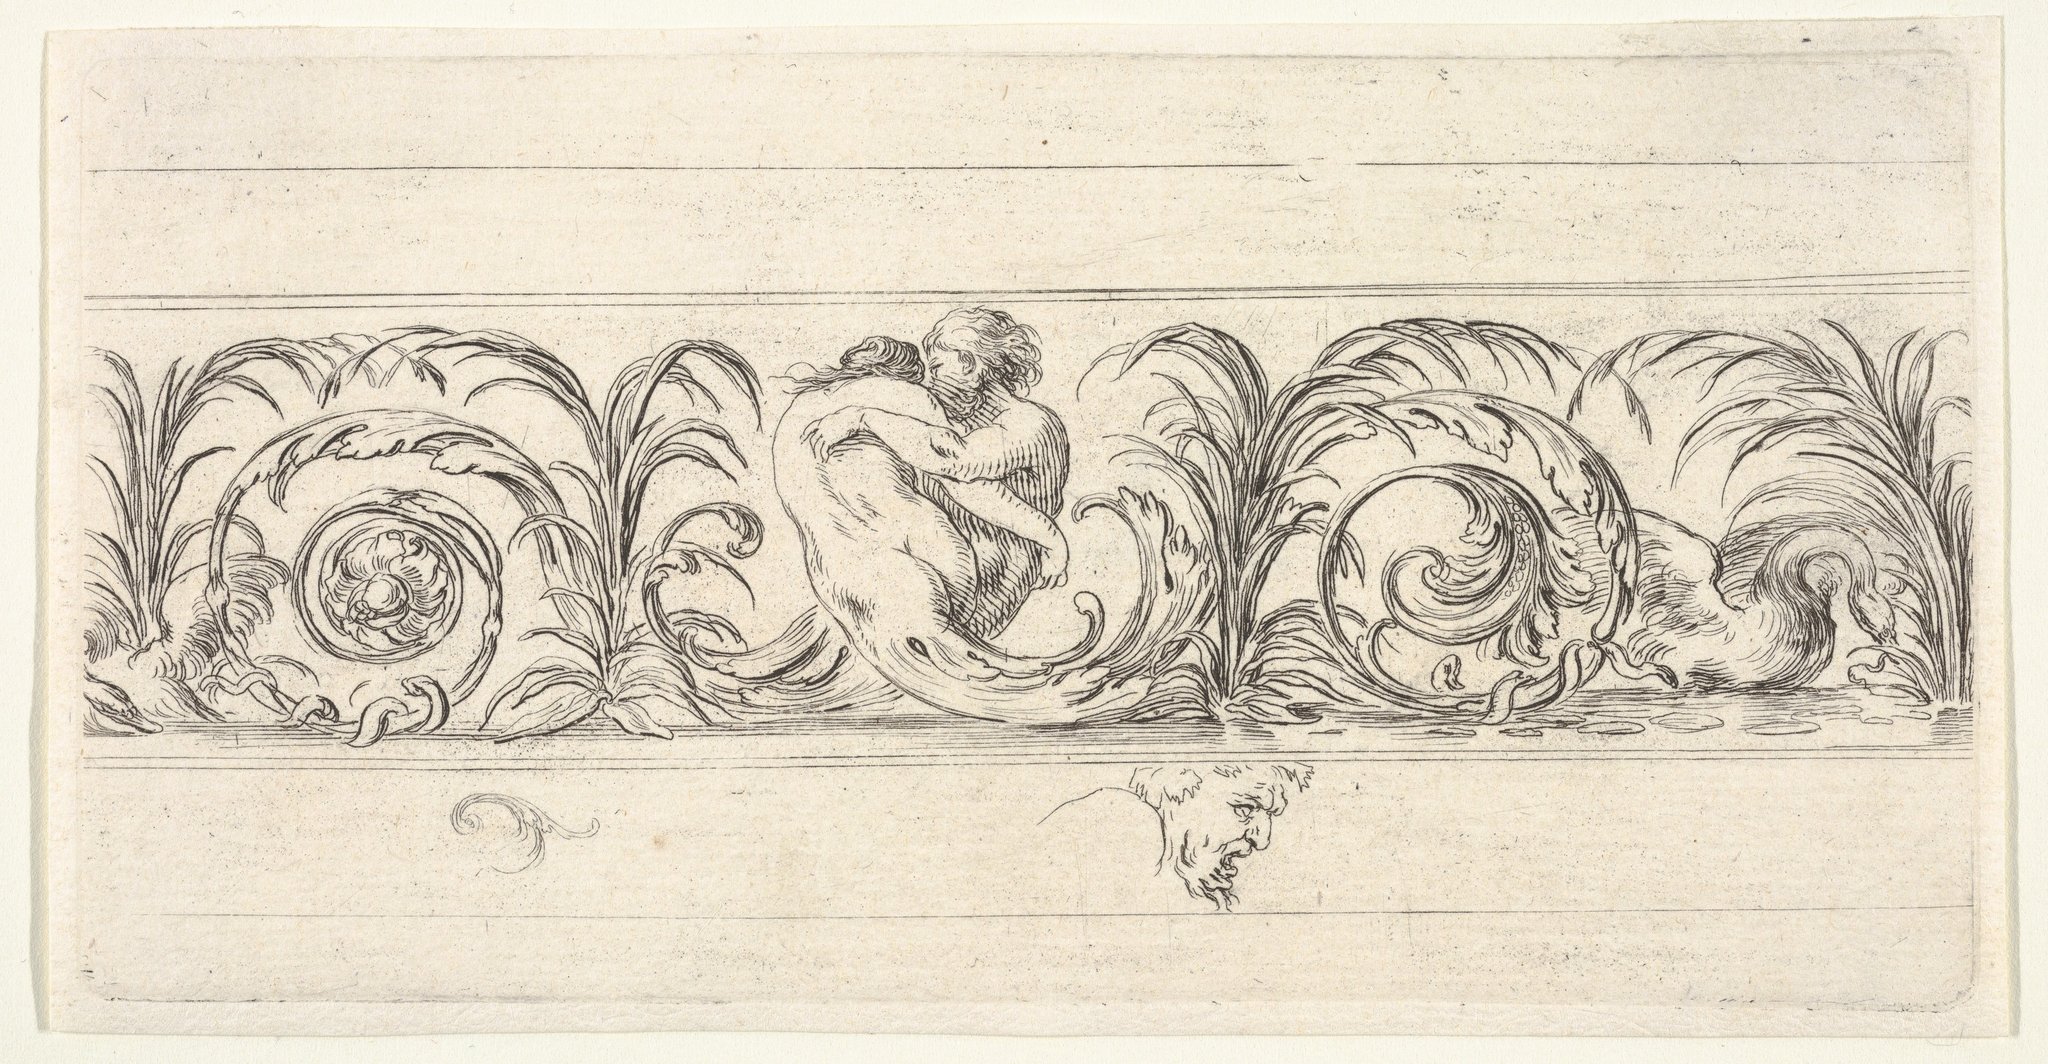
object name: print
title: A triton and a siren fighting at center, their legs as scrollwork, a swan to right, the grotesque head of an old man below, plate 6 from "Friezes, foliage, and grotesques" (Frises, feuillages et grotesques)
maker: stefano della bella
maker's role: artist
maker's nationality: italian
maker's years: 1610-1664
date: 1638-1643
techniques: etching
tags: ornament,triton,swans